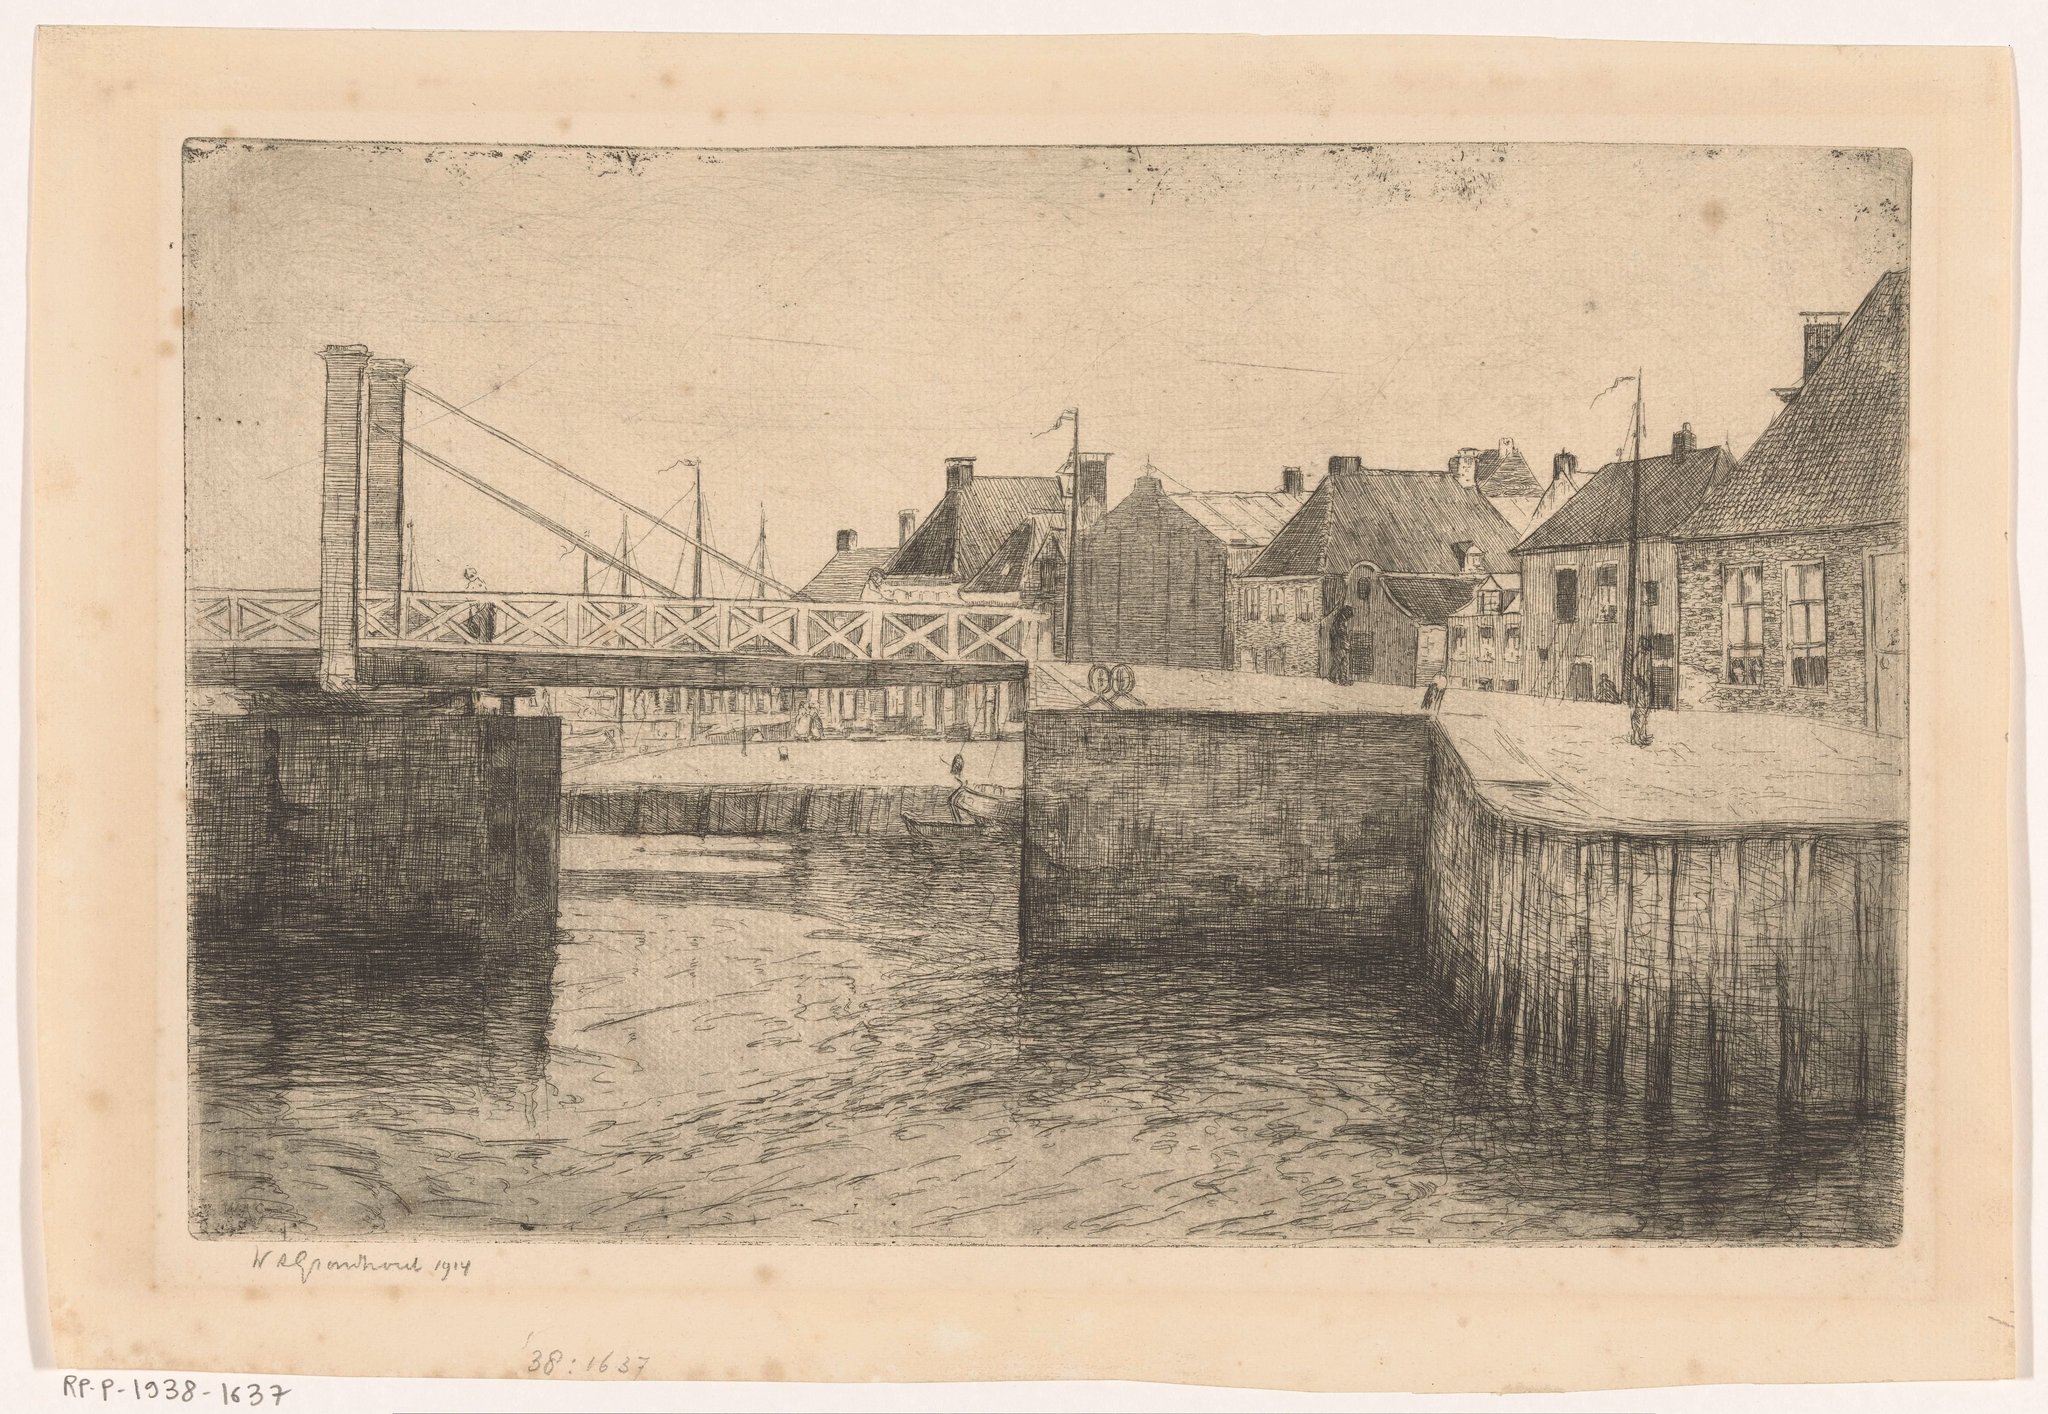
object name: print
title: Ophaalbrug in Harlingen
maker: willem adrianus grondhout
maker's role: draughtsman, painter, print maker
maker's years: 1878-1934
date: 1914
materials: paper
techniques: etching, intaglio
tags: city-view, and landscape with man-made constructions, bascule bridge, harlingen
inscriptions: collector's mark: Lugt 2228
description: Op de achtergrond huizen en afgemeerde schepen aan een kade.